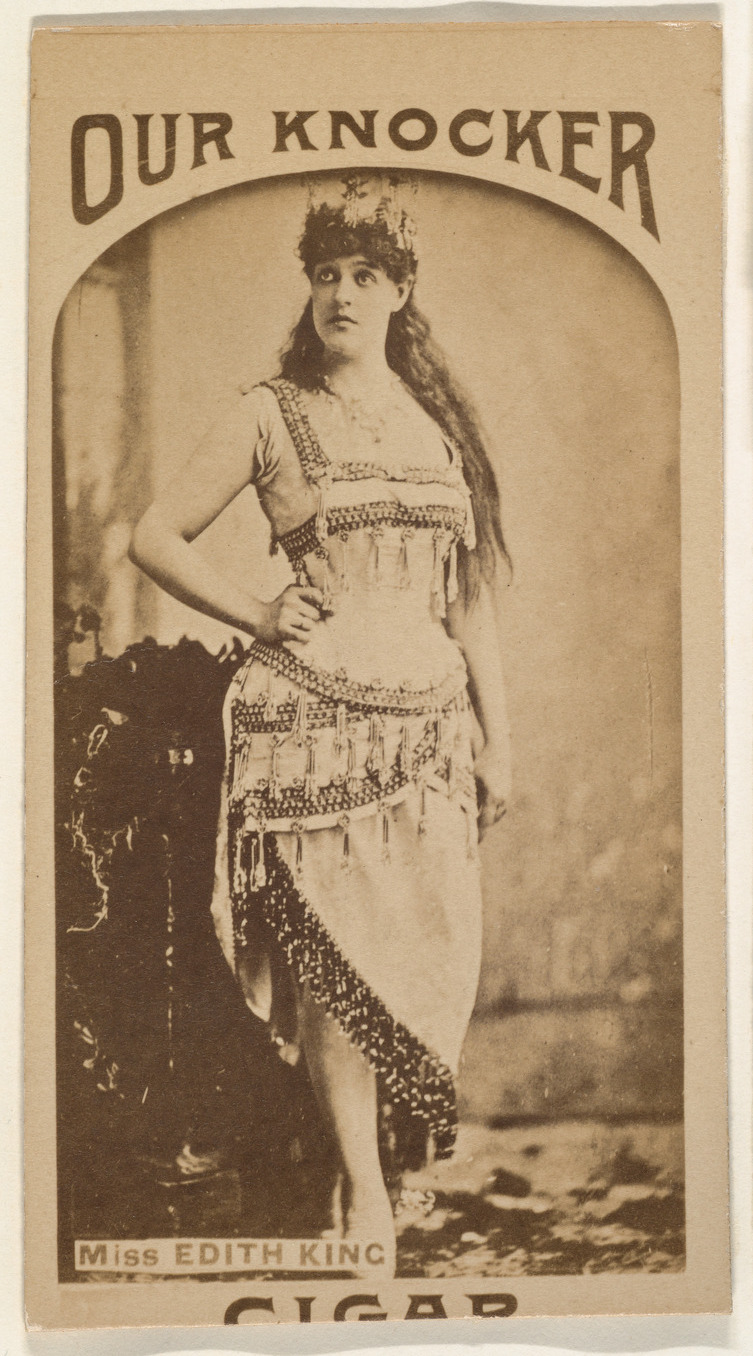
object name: photograph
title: Miss Edith King, from the Actresses series (N665) promoting Our Knocker Cigars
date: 1888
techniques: albumen silver print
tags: portraits,women,actresses